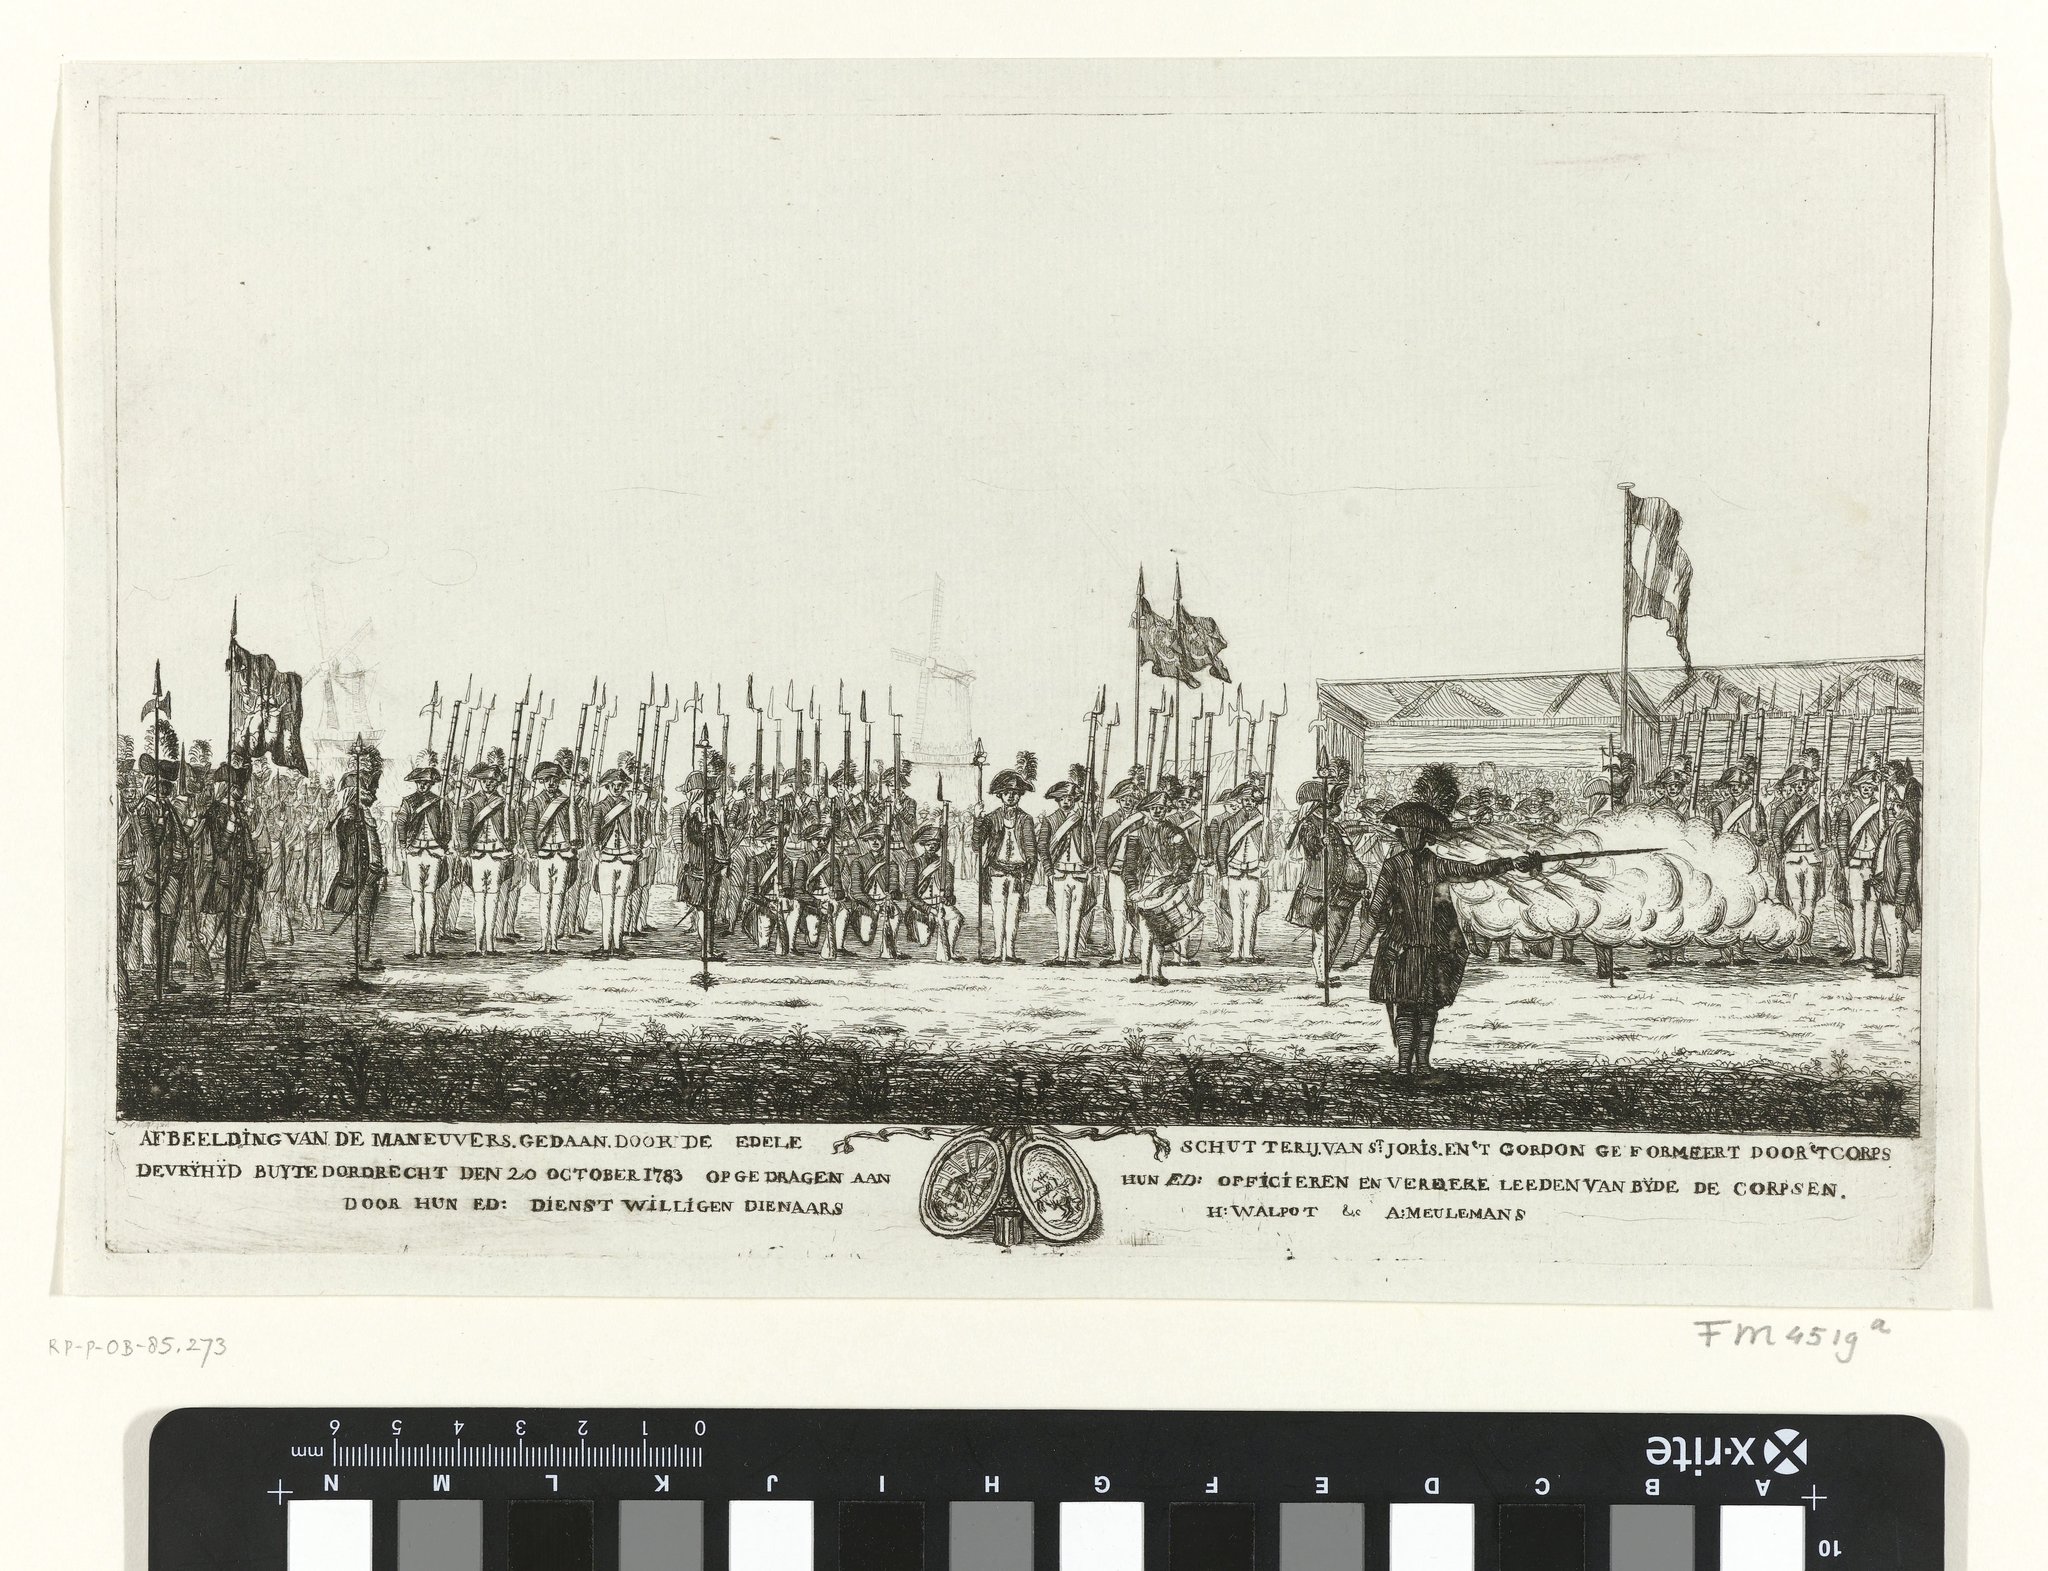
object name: print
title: Oefeningen van de schutterij van Dordrecht, 1783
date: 1783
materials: paper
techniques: etching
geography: amsterdam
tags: drill ~ military training (+ citizen soldiery, civil guard, citizen militia), dordrecht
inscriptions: collector's mark: Lugt 2228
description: Exercitie en schietoefening van de schutterij van St. Joris en het vrijkorps De Vrijheid, buiten Dordrecht, 20 oktober 1783.